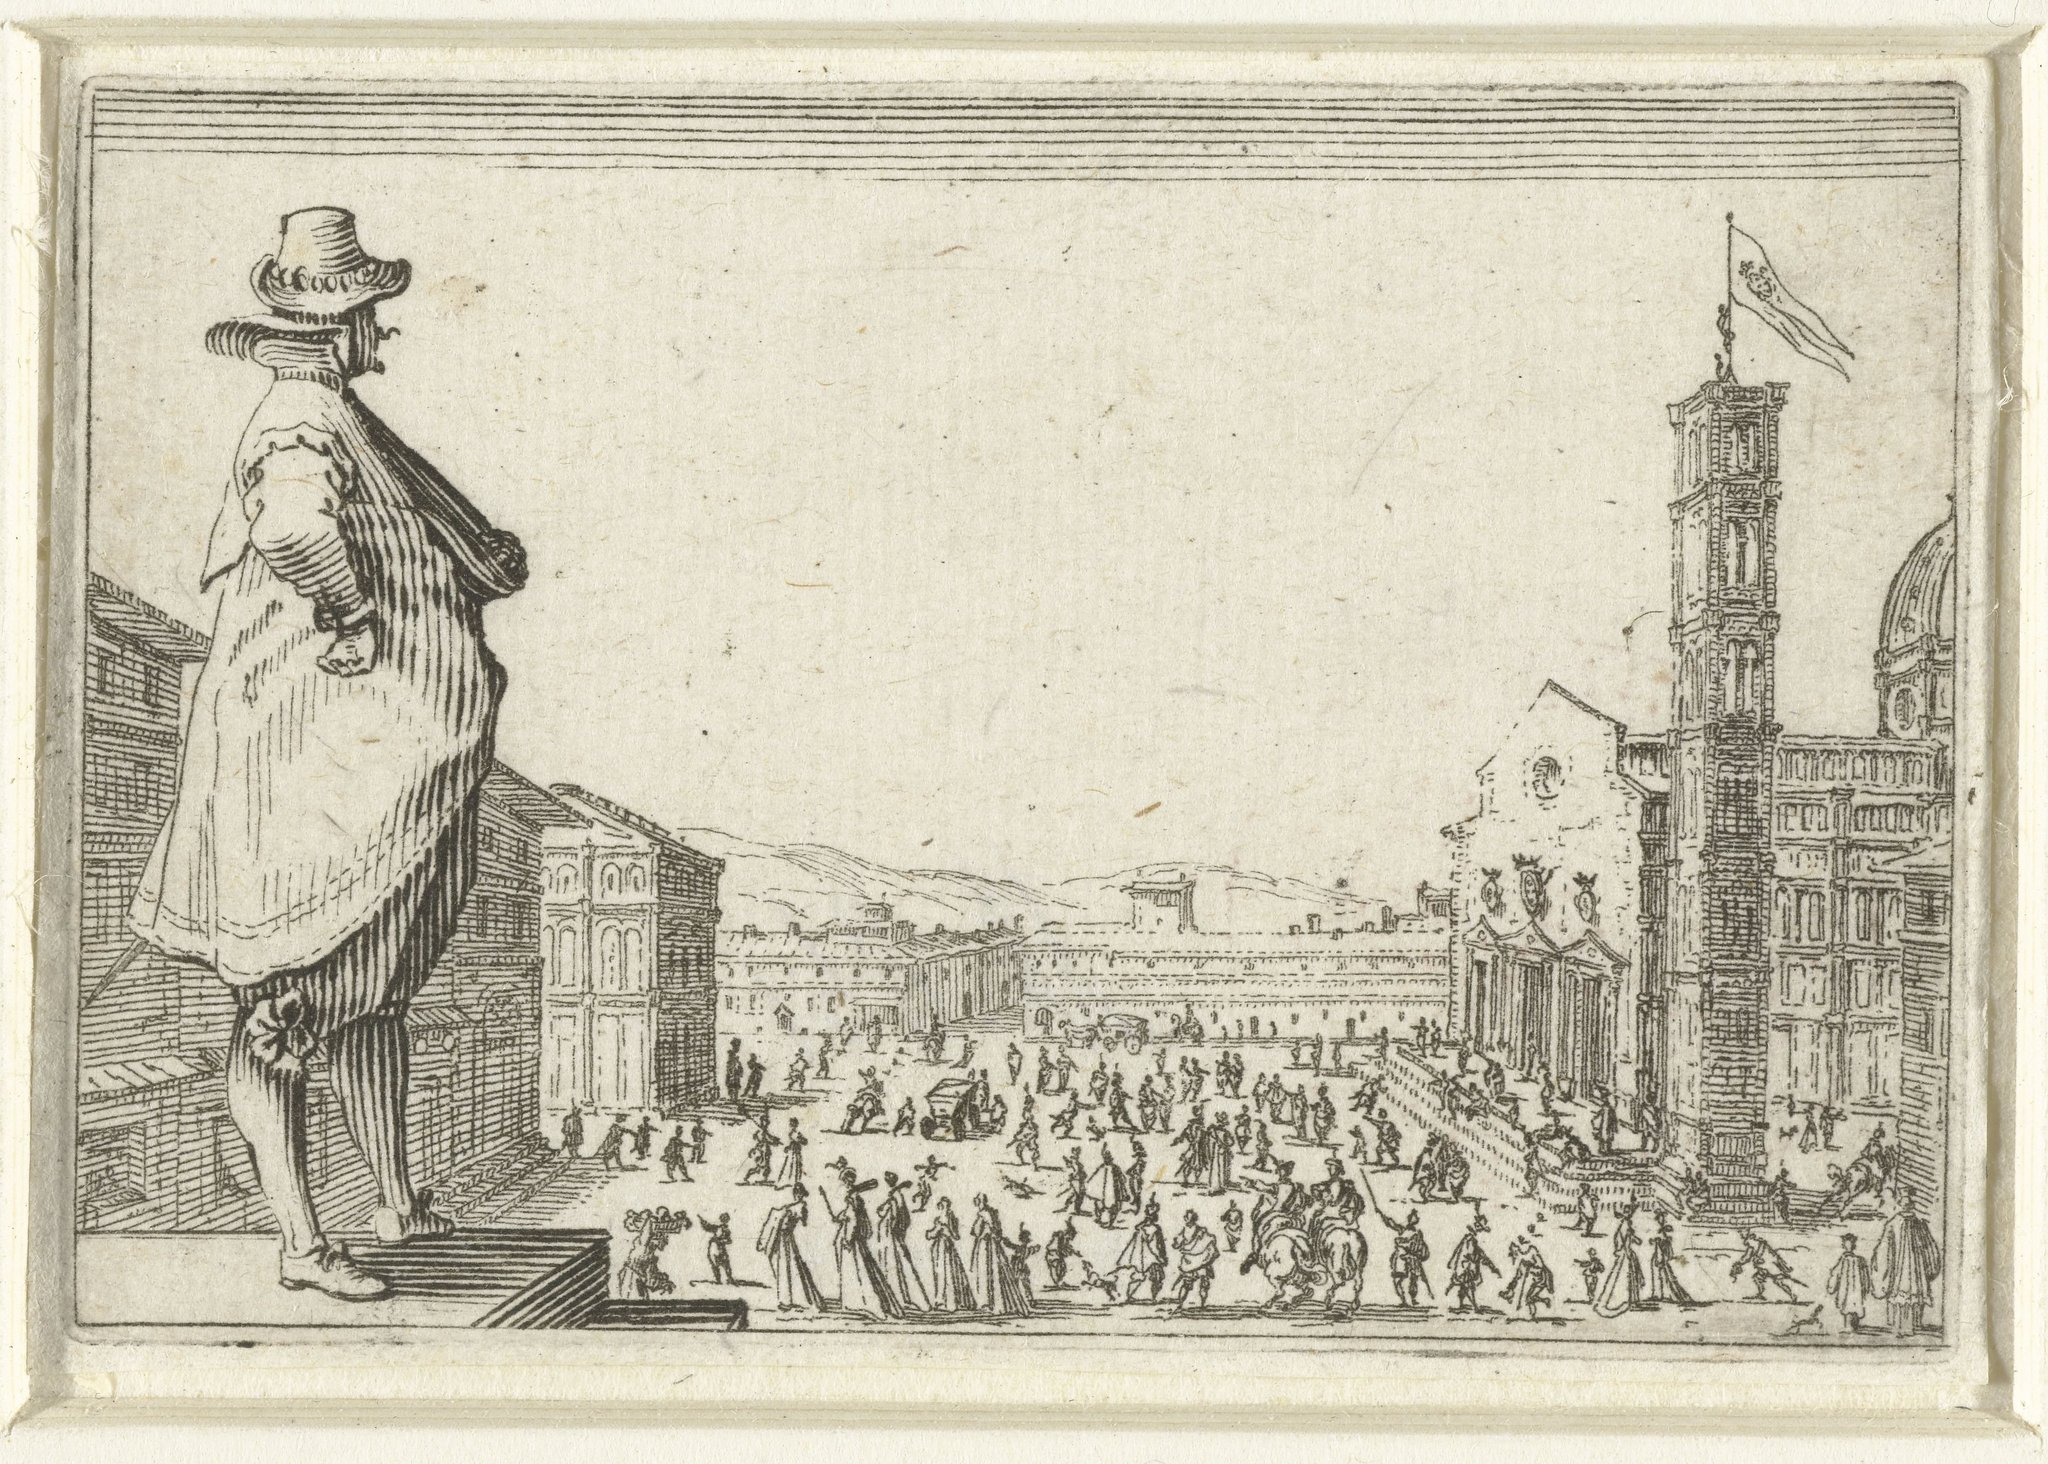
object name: print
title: Diverse figuren en voorstellingen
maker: jacques callot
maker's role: draughtsman, print maker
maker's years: 1592-1635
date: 1621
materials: paper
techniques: etching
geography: nancy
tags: village square, place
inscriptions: collector's mark: Lugt 240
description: Links op de voorgrond staat een heer met een hoed op en een hand in de zij. Op de achtergrond de Piazza del Duomo te Florence, waarop het een drukte van belang is. Deze prent is onderdeel van een serie van 48 prenten (50 incl. titelblad en dedicatieblad) met diverse onderwerpen (o.a. mannen en vrouwen in verschillende houdingen, landschappen, gebouwen en festiviteiten in Florence). Mogelijk zijn deze prenten bedoeld geweest als tekenvoorbeelden.